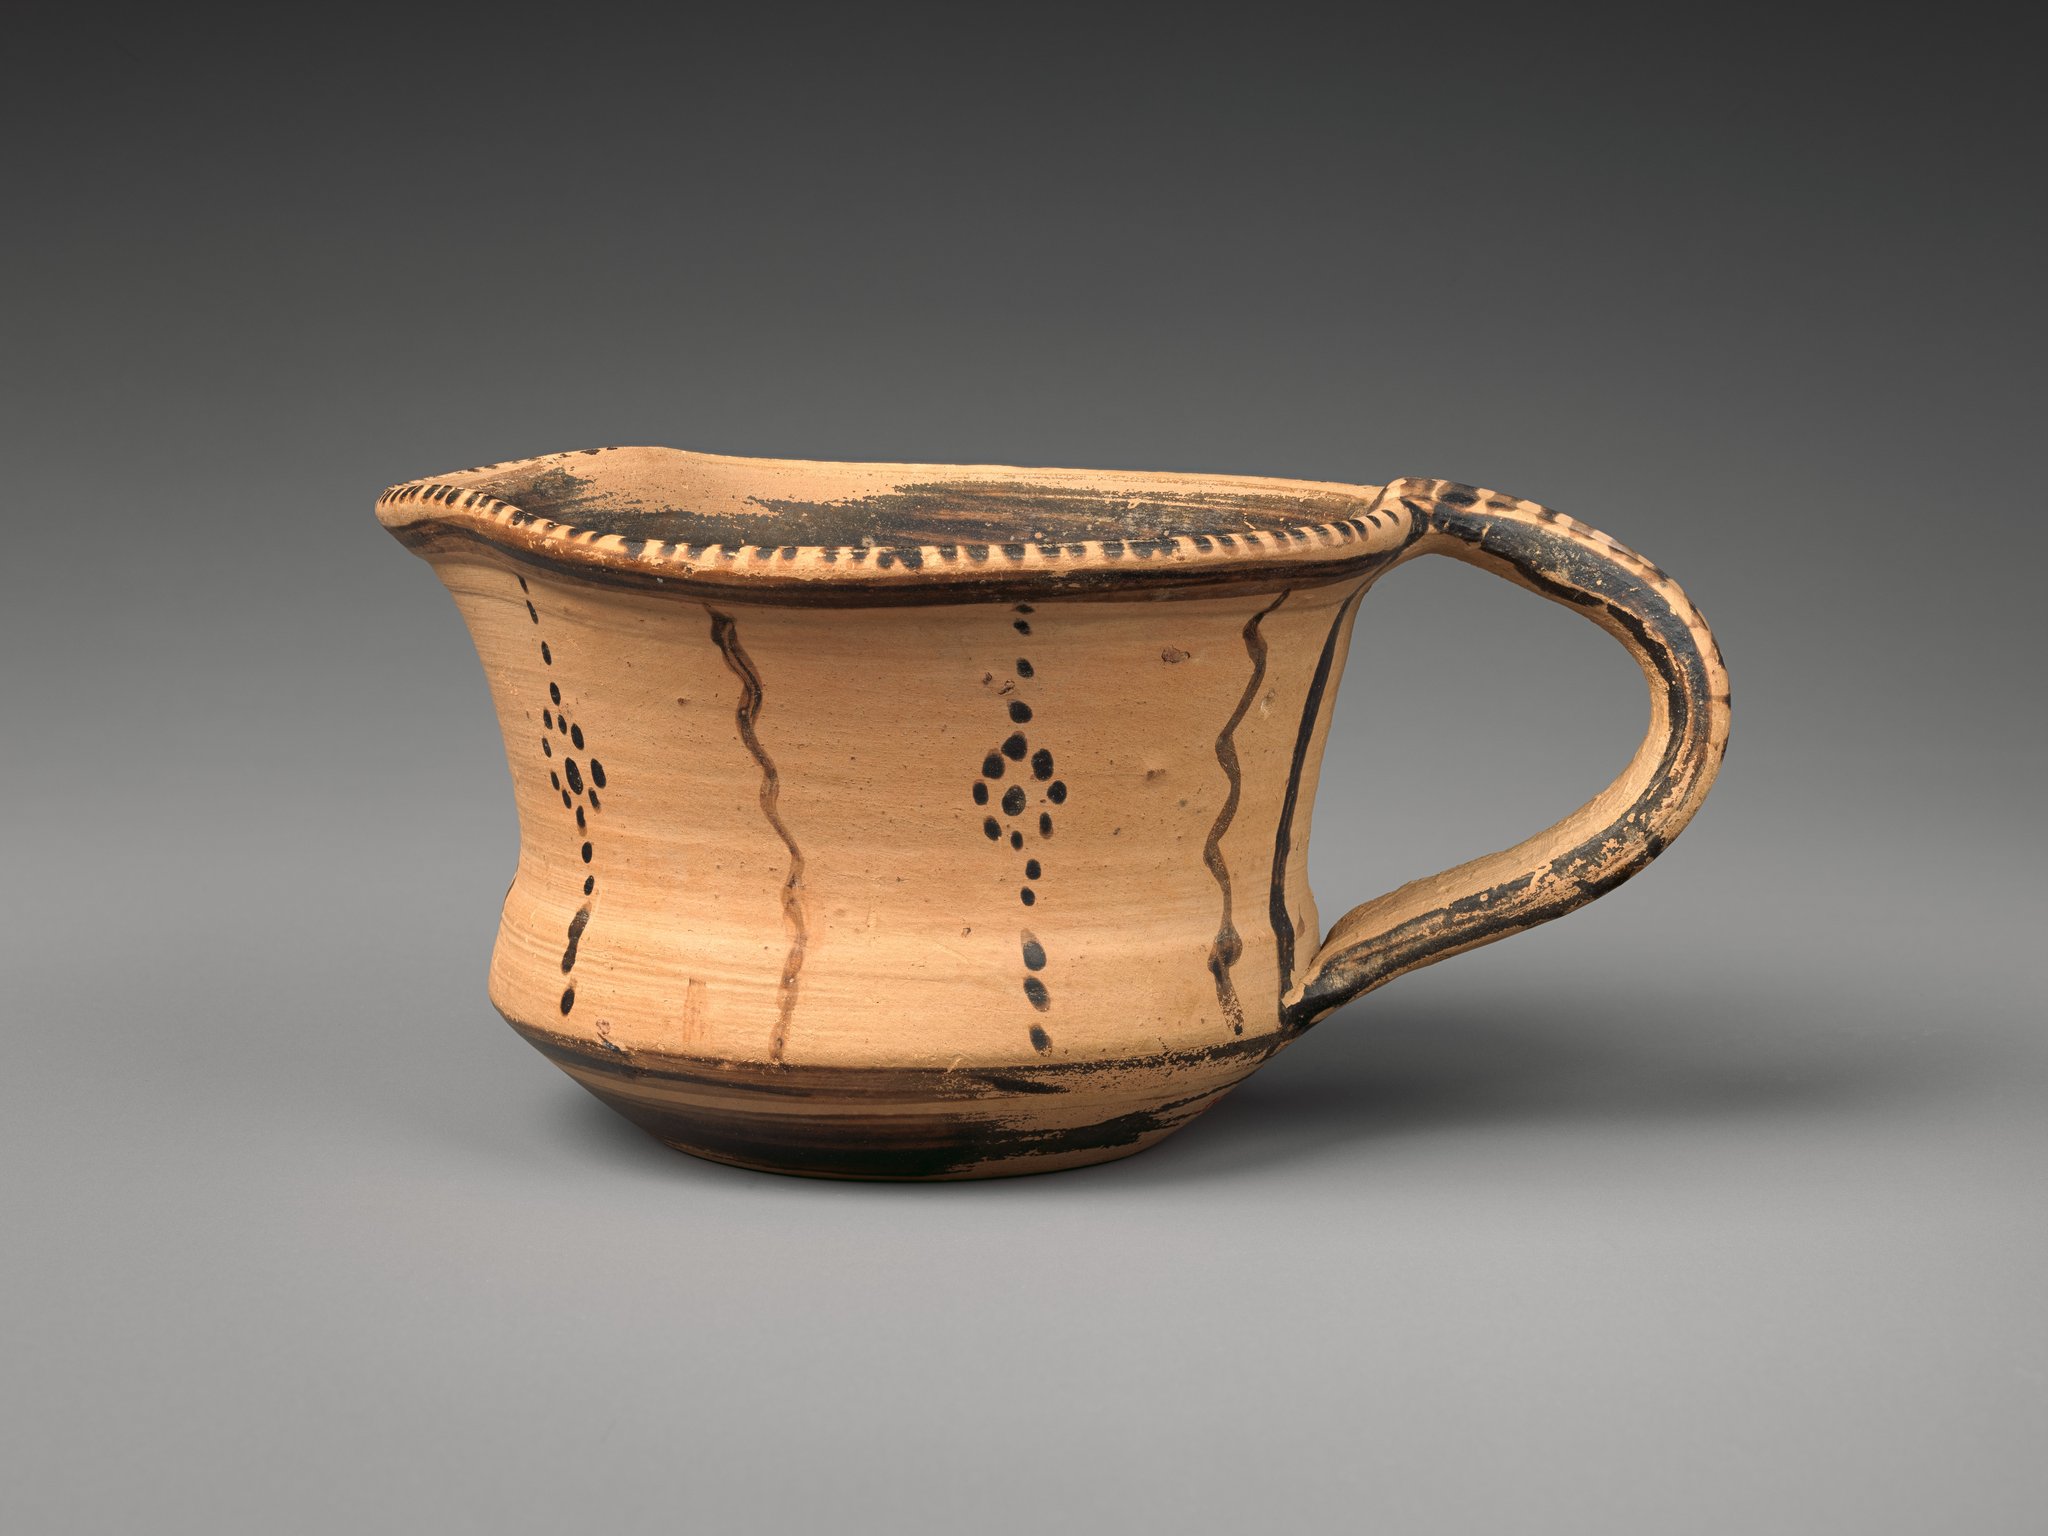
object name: cup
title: Terracotta cup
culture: greek, attic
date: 800-750 BCE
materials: terracotta